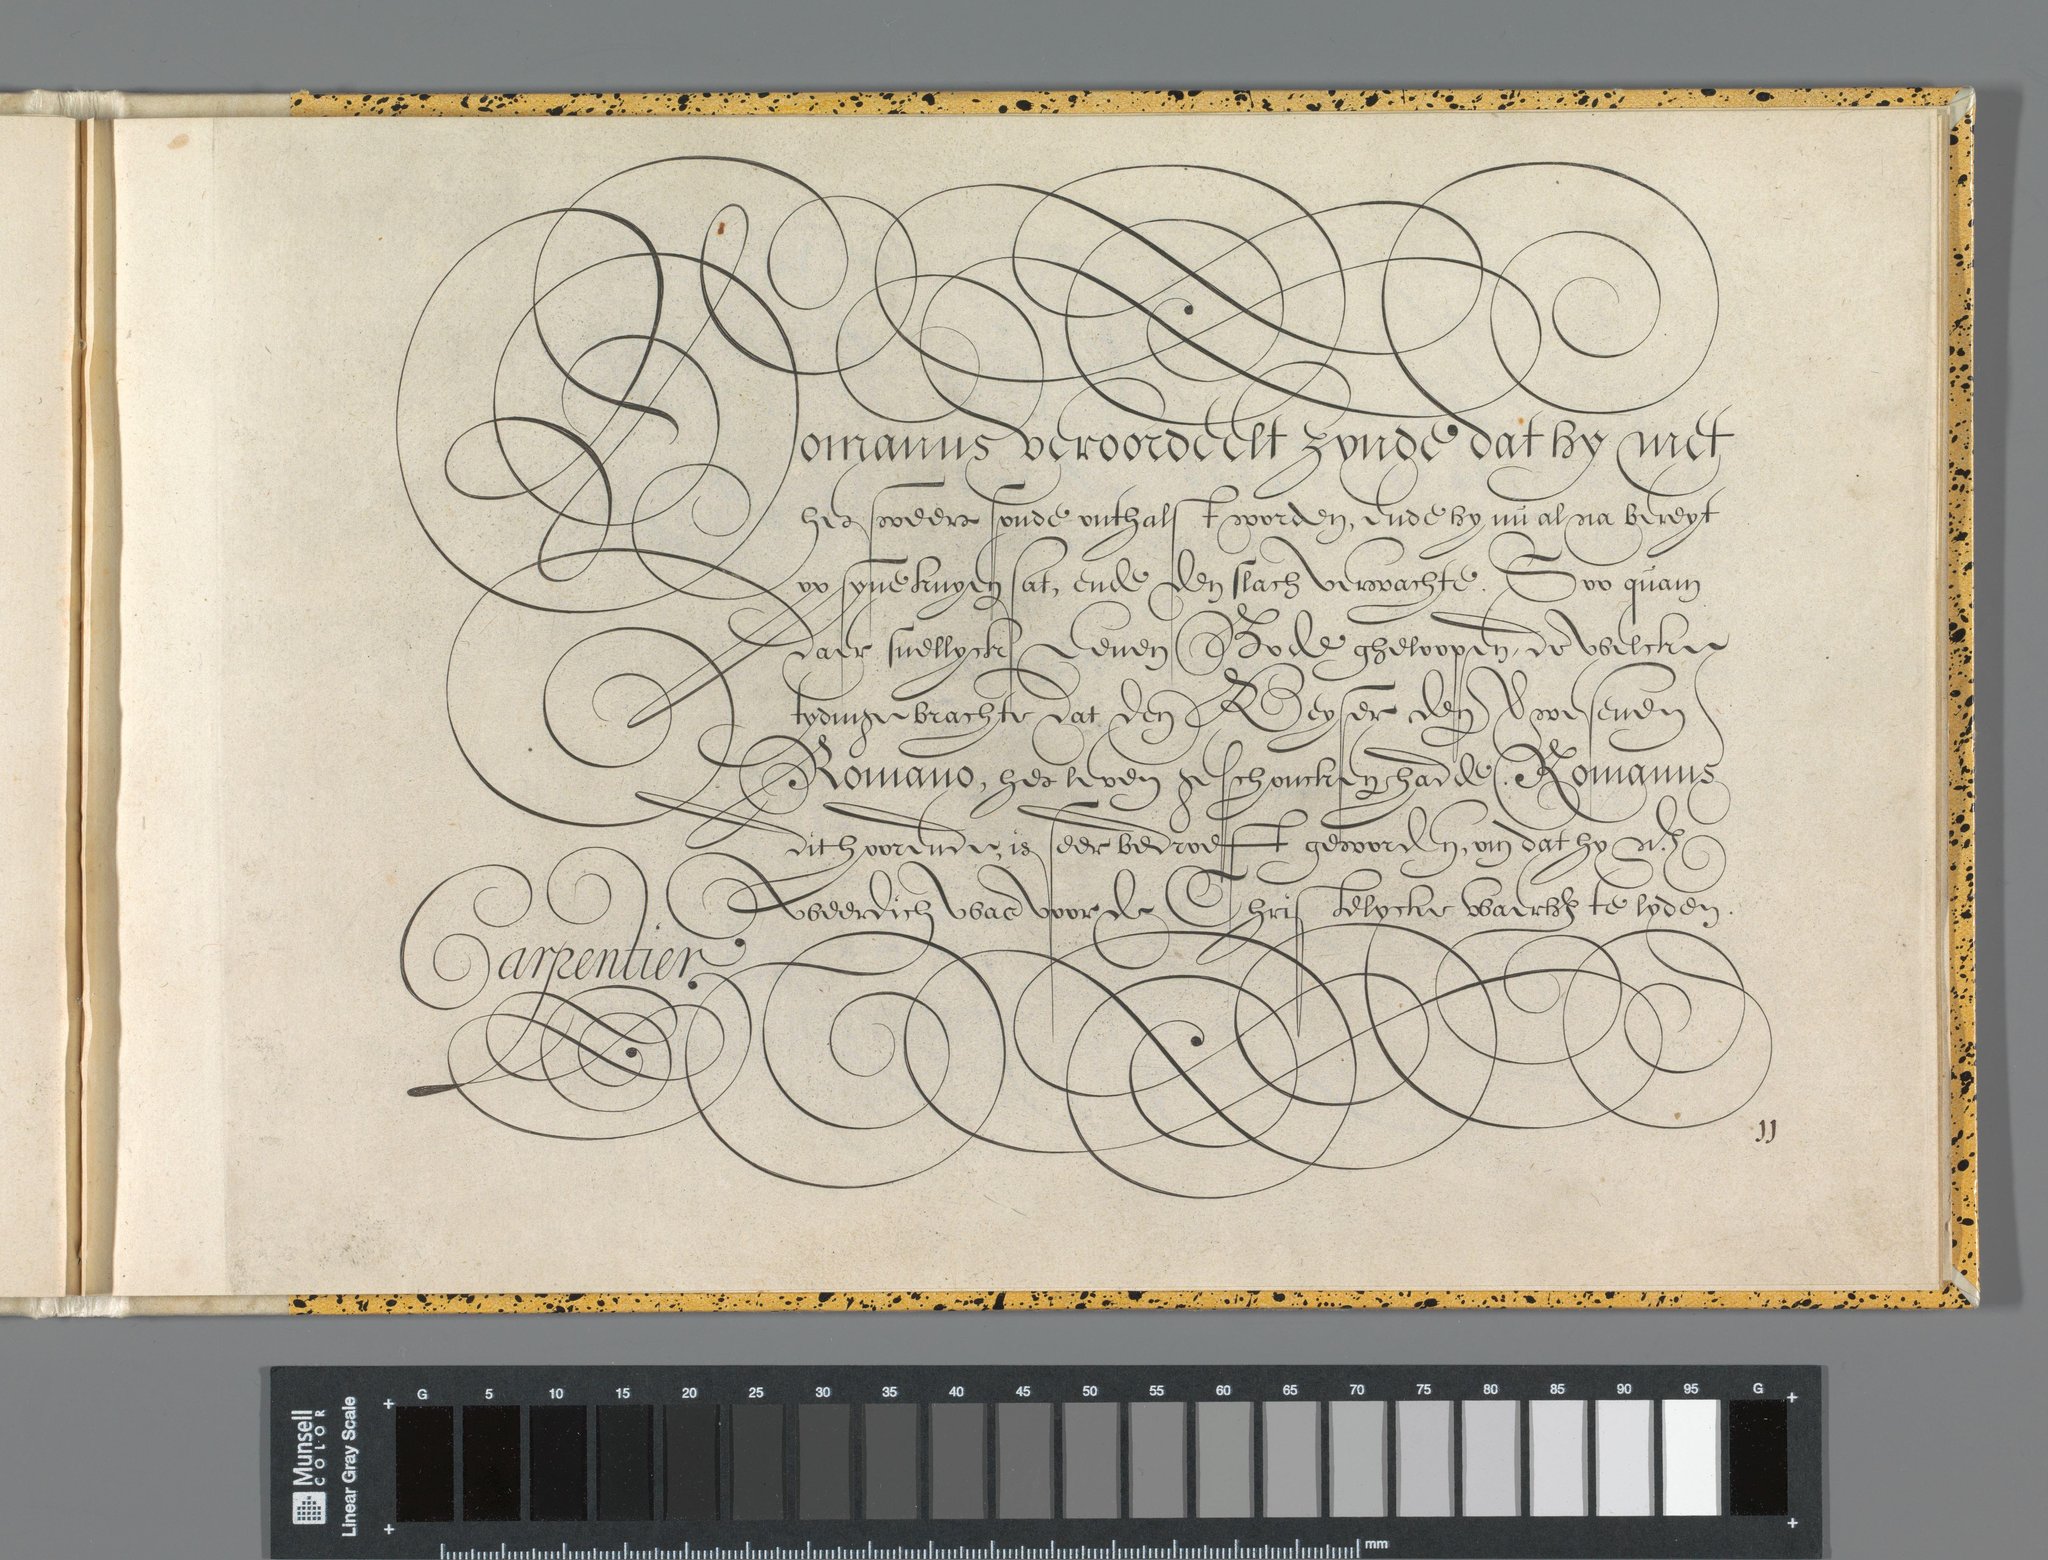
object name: ornament print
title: Exemplaer-Boeck. Inhoudende d'alder-gebruyckelyckste Geschriften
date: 1618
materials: paper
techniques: engraving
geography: amsterdam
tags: calligraphy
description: Schrijfvoorbeeld met de tekst: Romanus benoordeelt zynde dat hy niet (...). Deze prent maakt deel uit van een album.